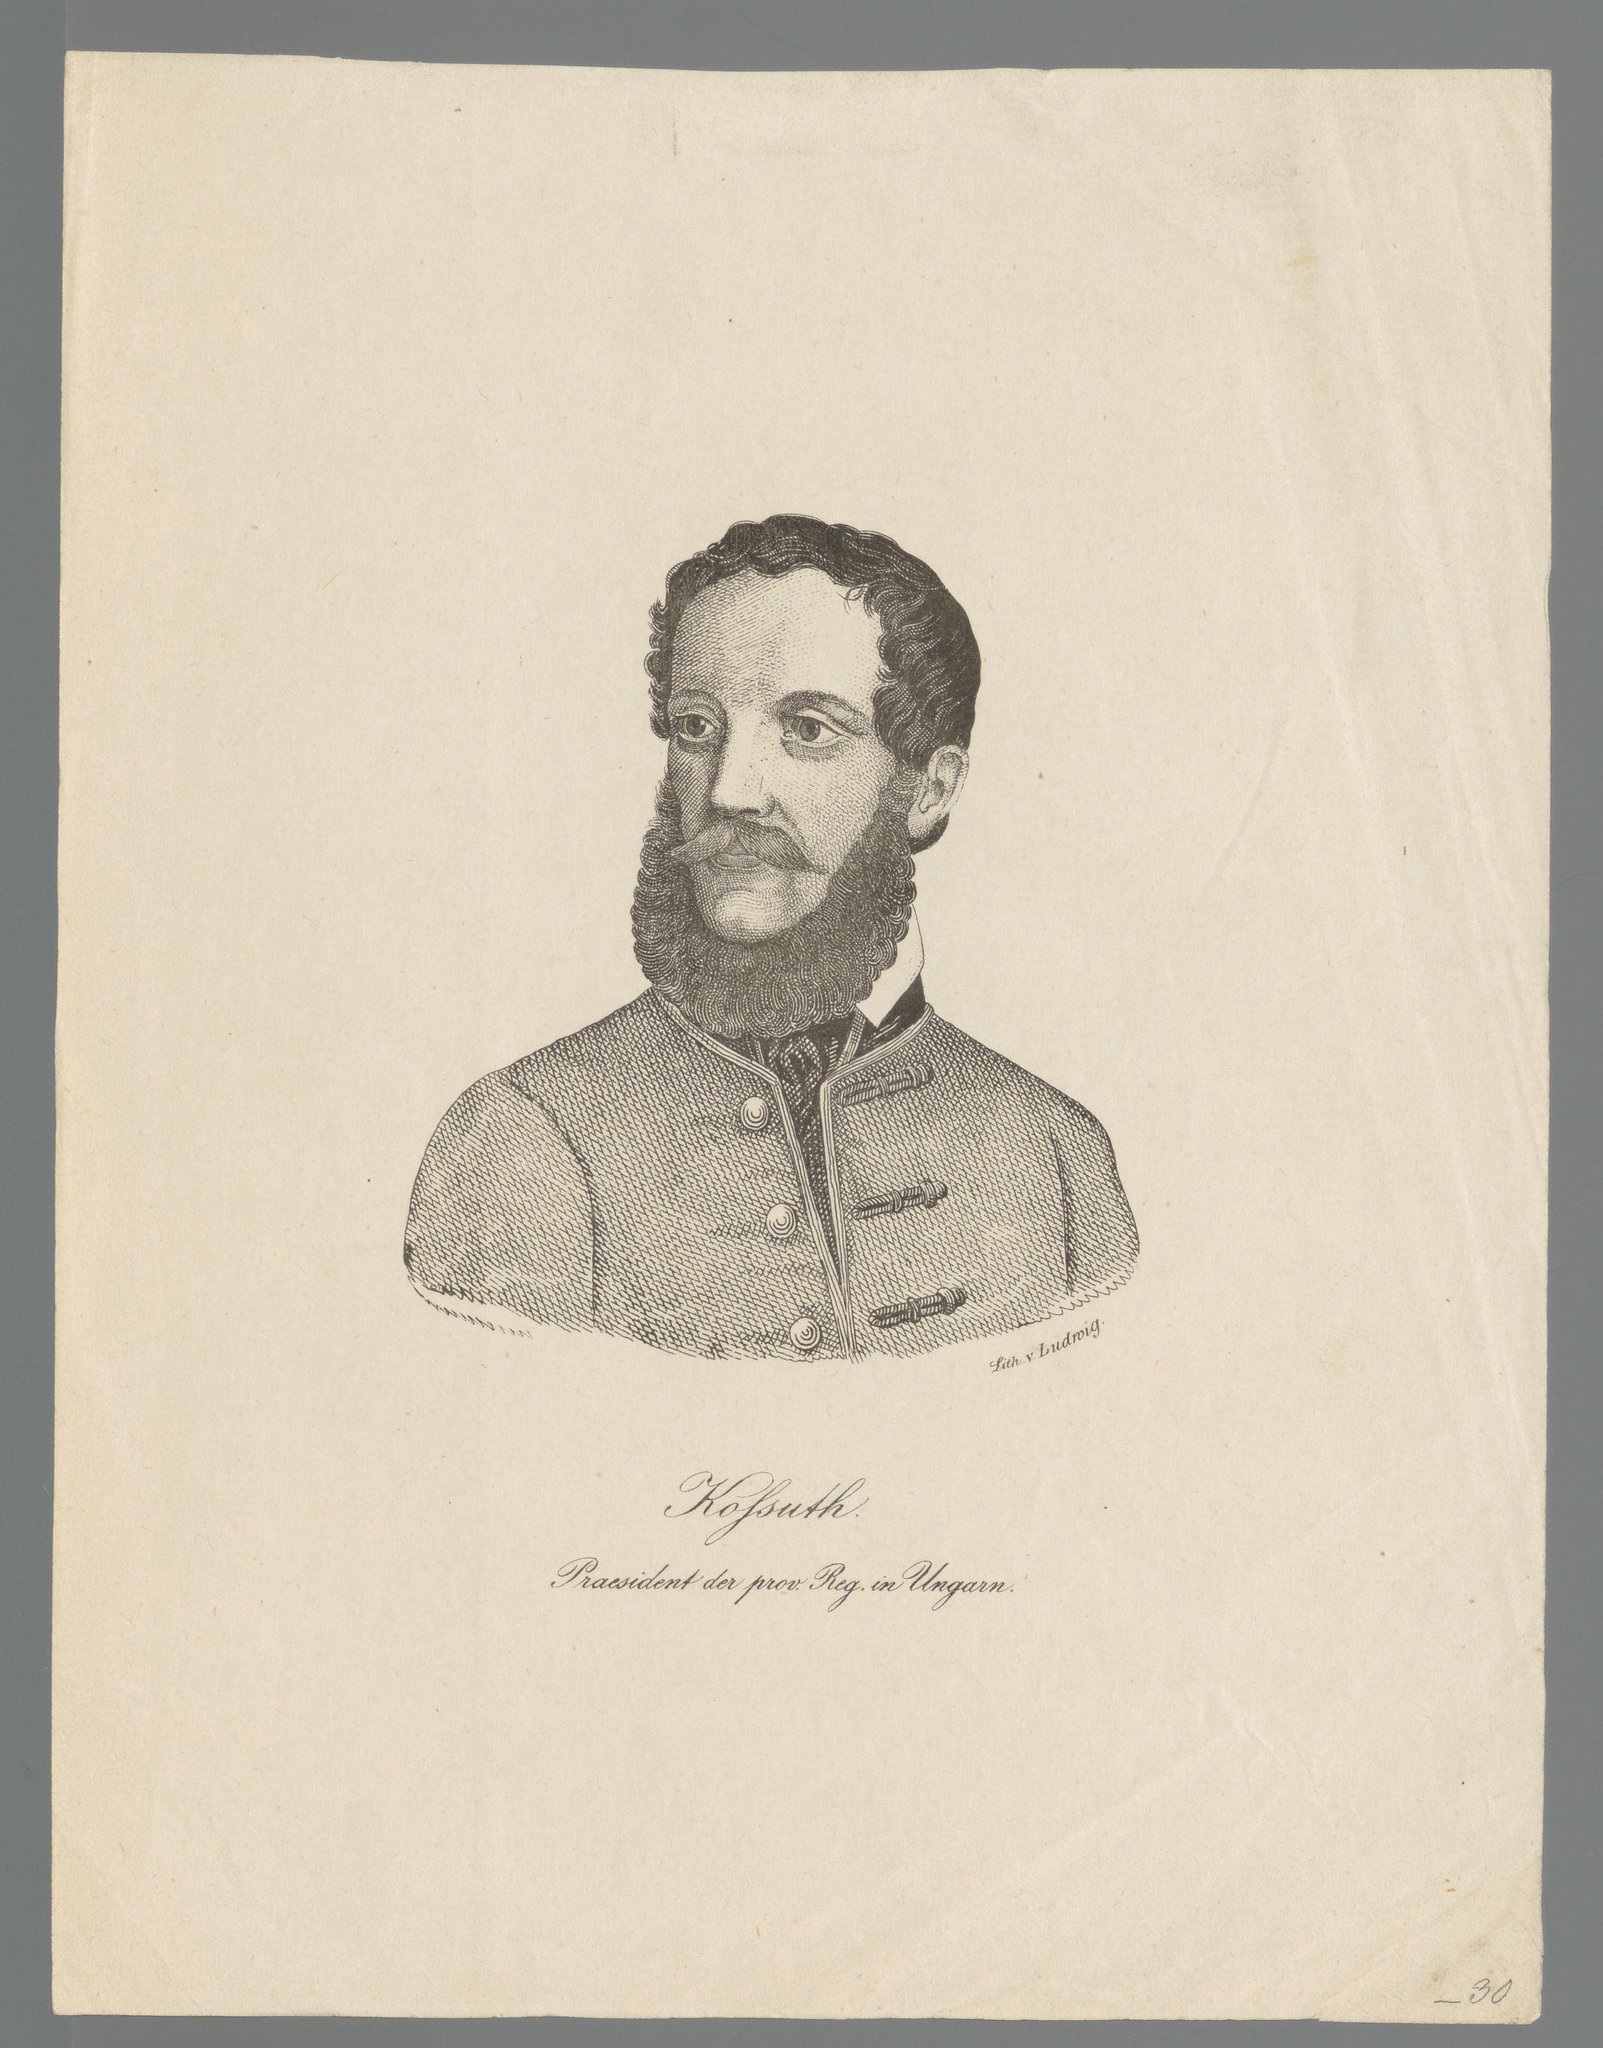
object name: print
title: Kossuth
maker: ludwig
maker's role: print maker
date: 1820-1880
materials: paper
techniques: lithograph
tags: politician, historical persons, politician, e.g. party leader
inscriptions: collector's mark: Lugt 2228